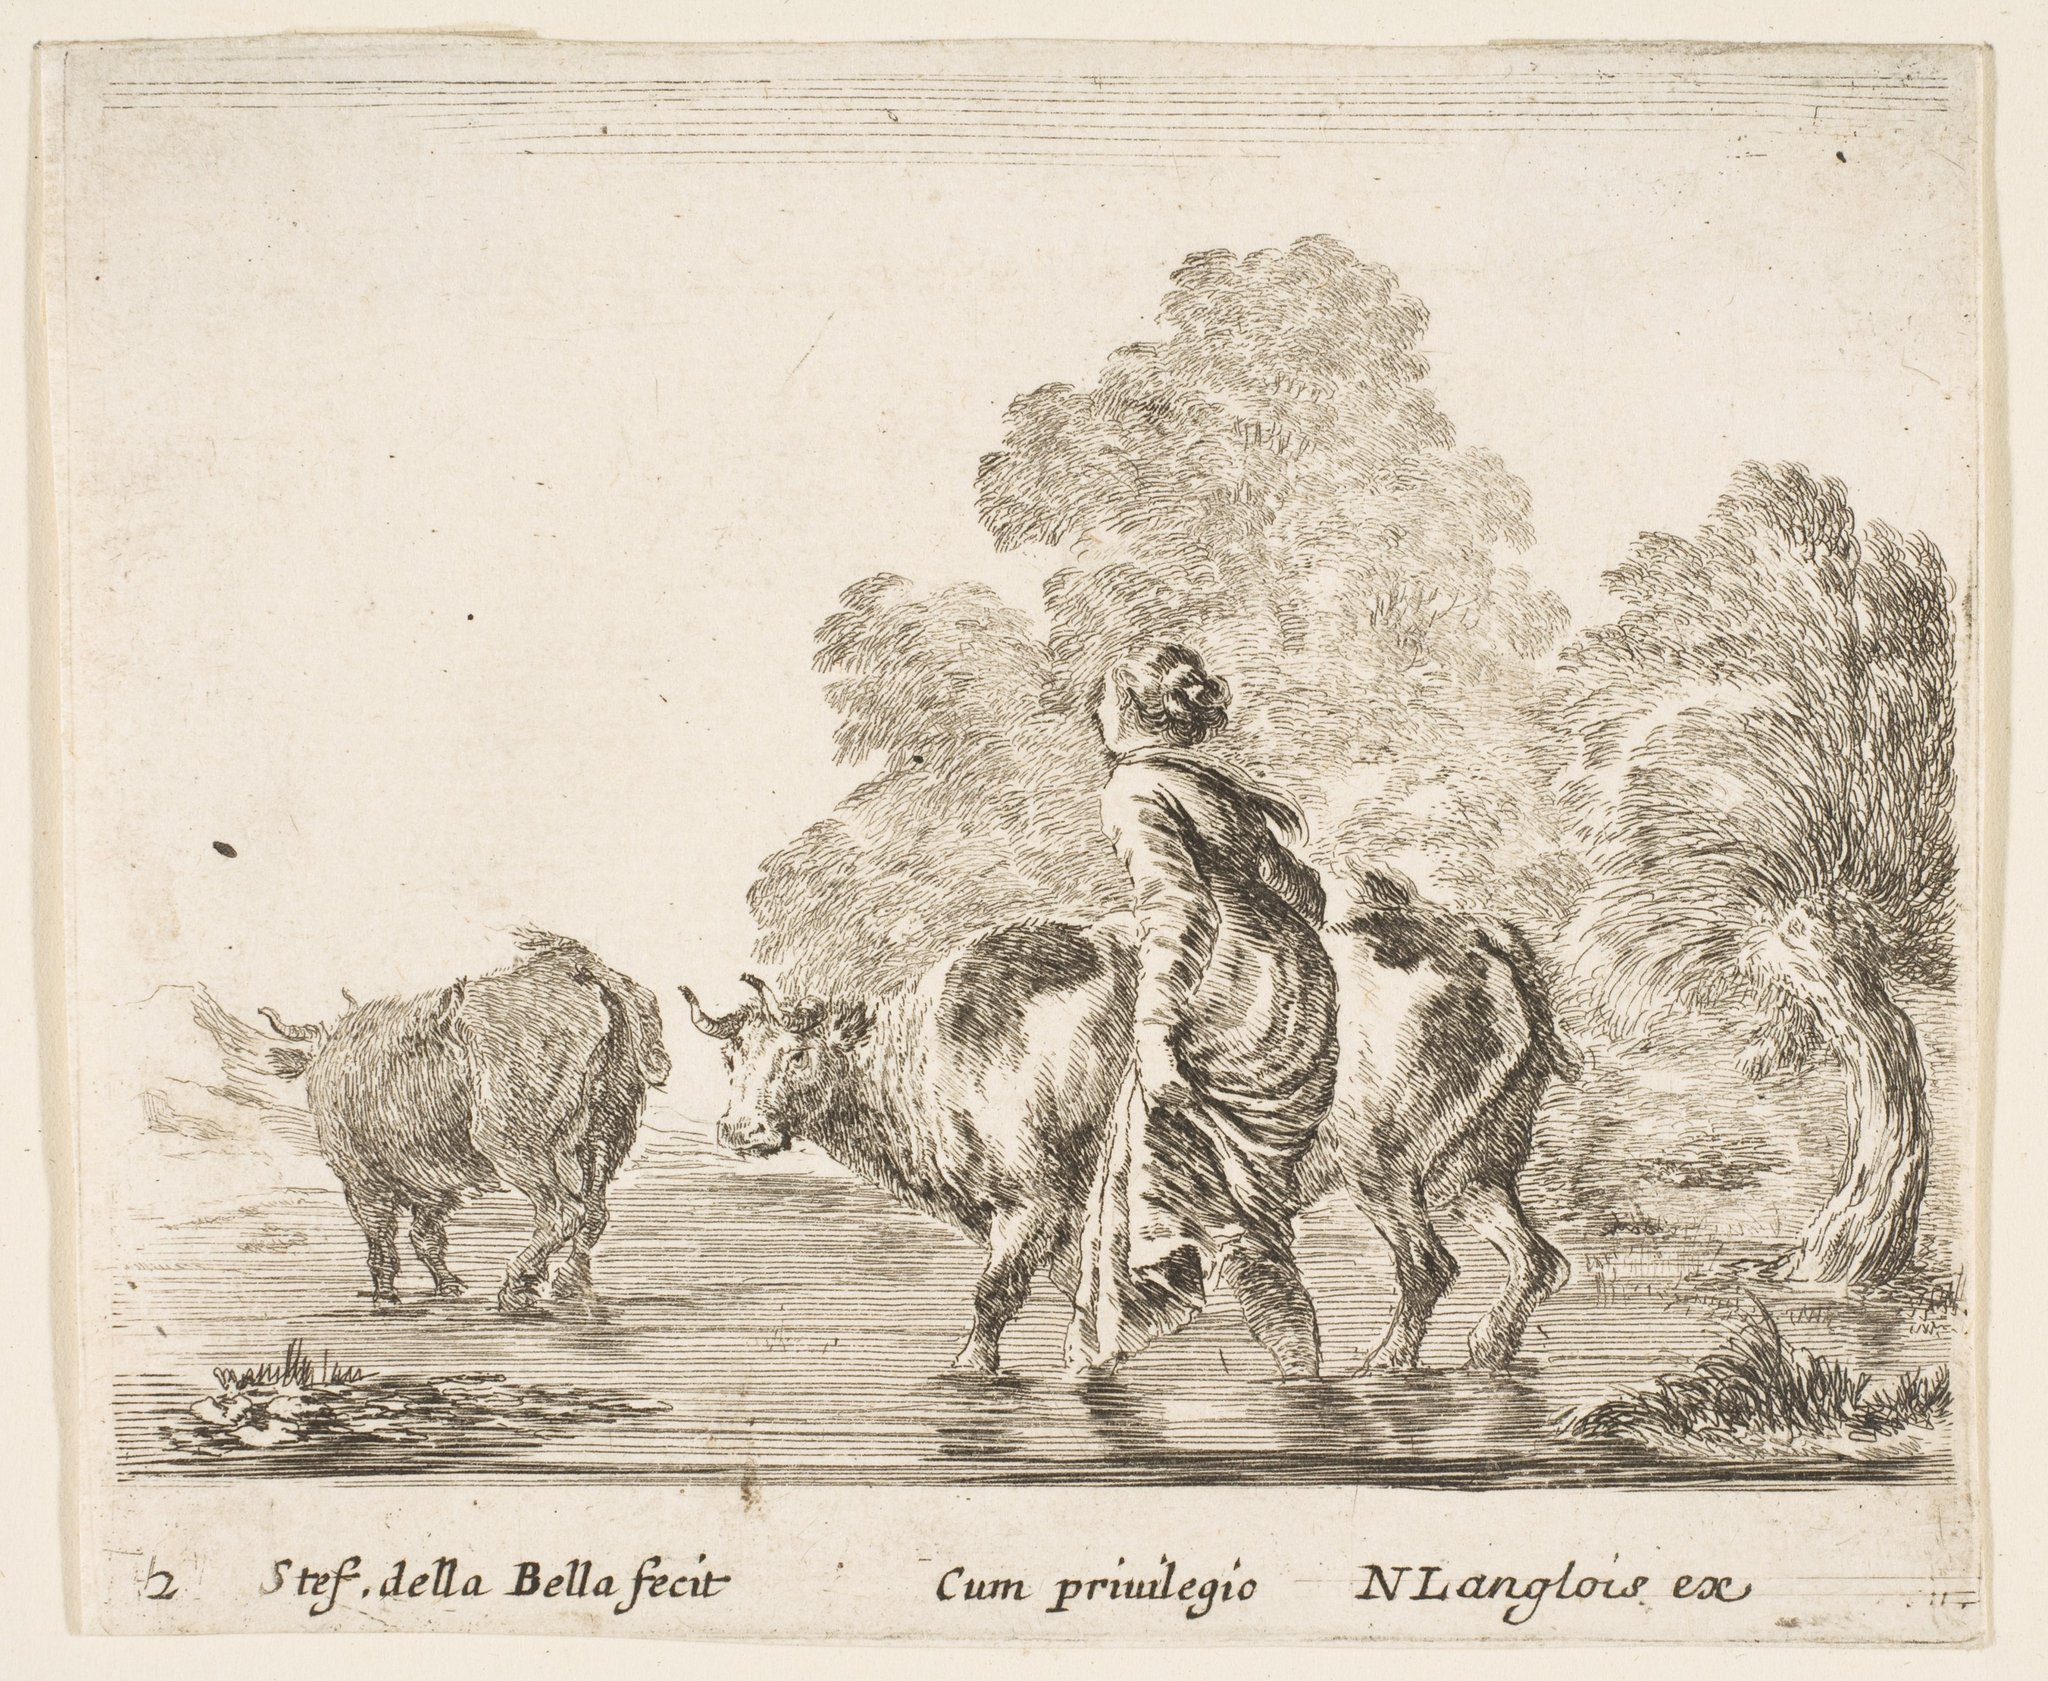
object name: print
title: A peasant woman herds two cows across a stream, walking towards the left, plate 2 from "Diversi capricci"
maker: stefano della bella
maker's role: artist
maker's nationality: italian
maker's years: 1610-1664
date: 1644-1647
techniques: etching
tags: women,cows